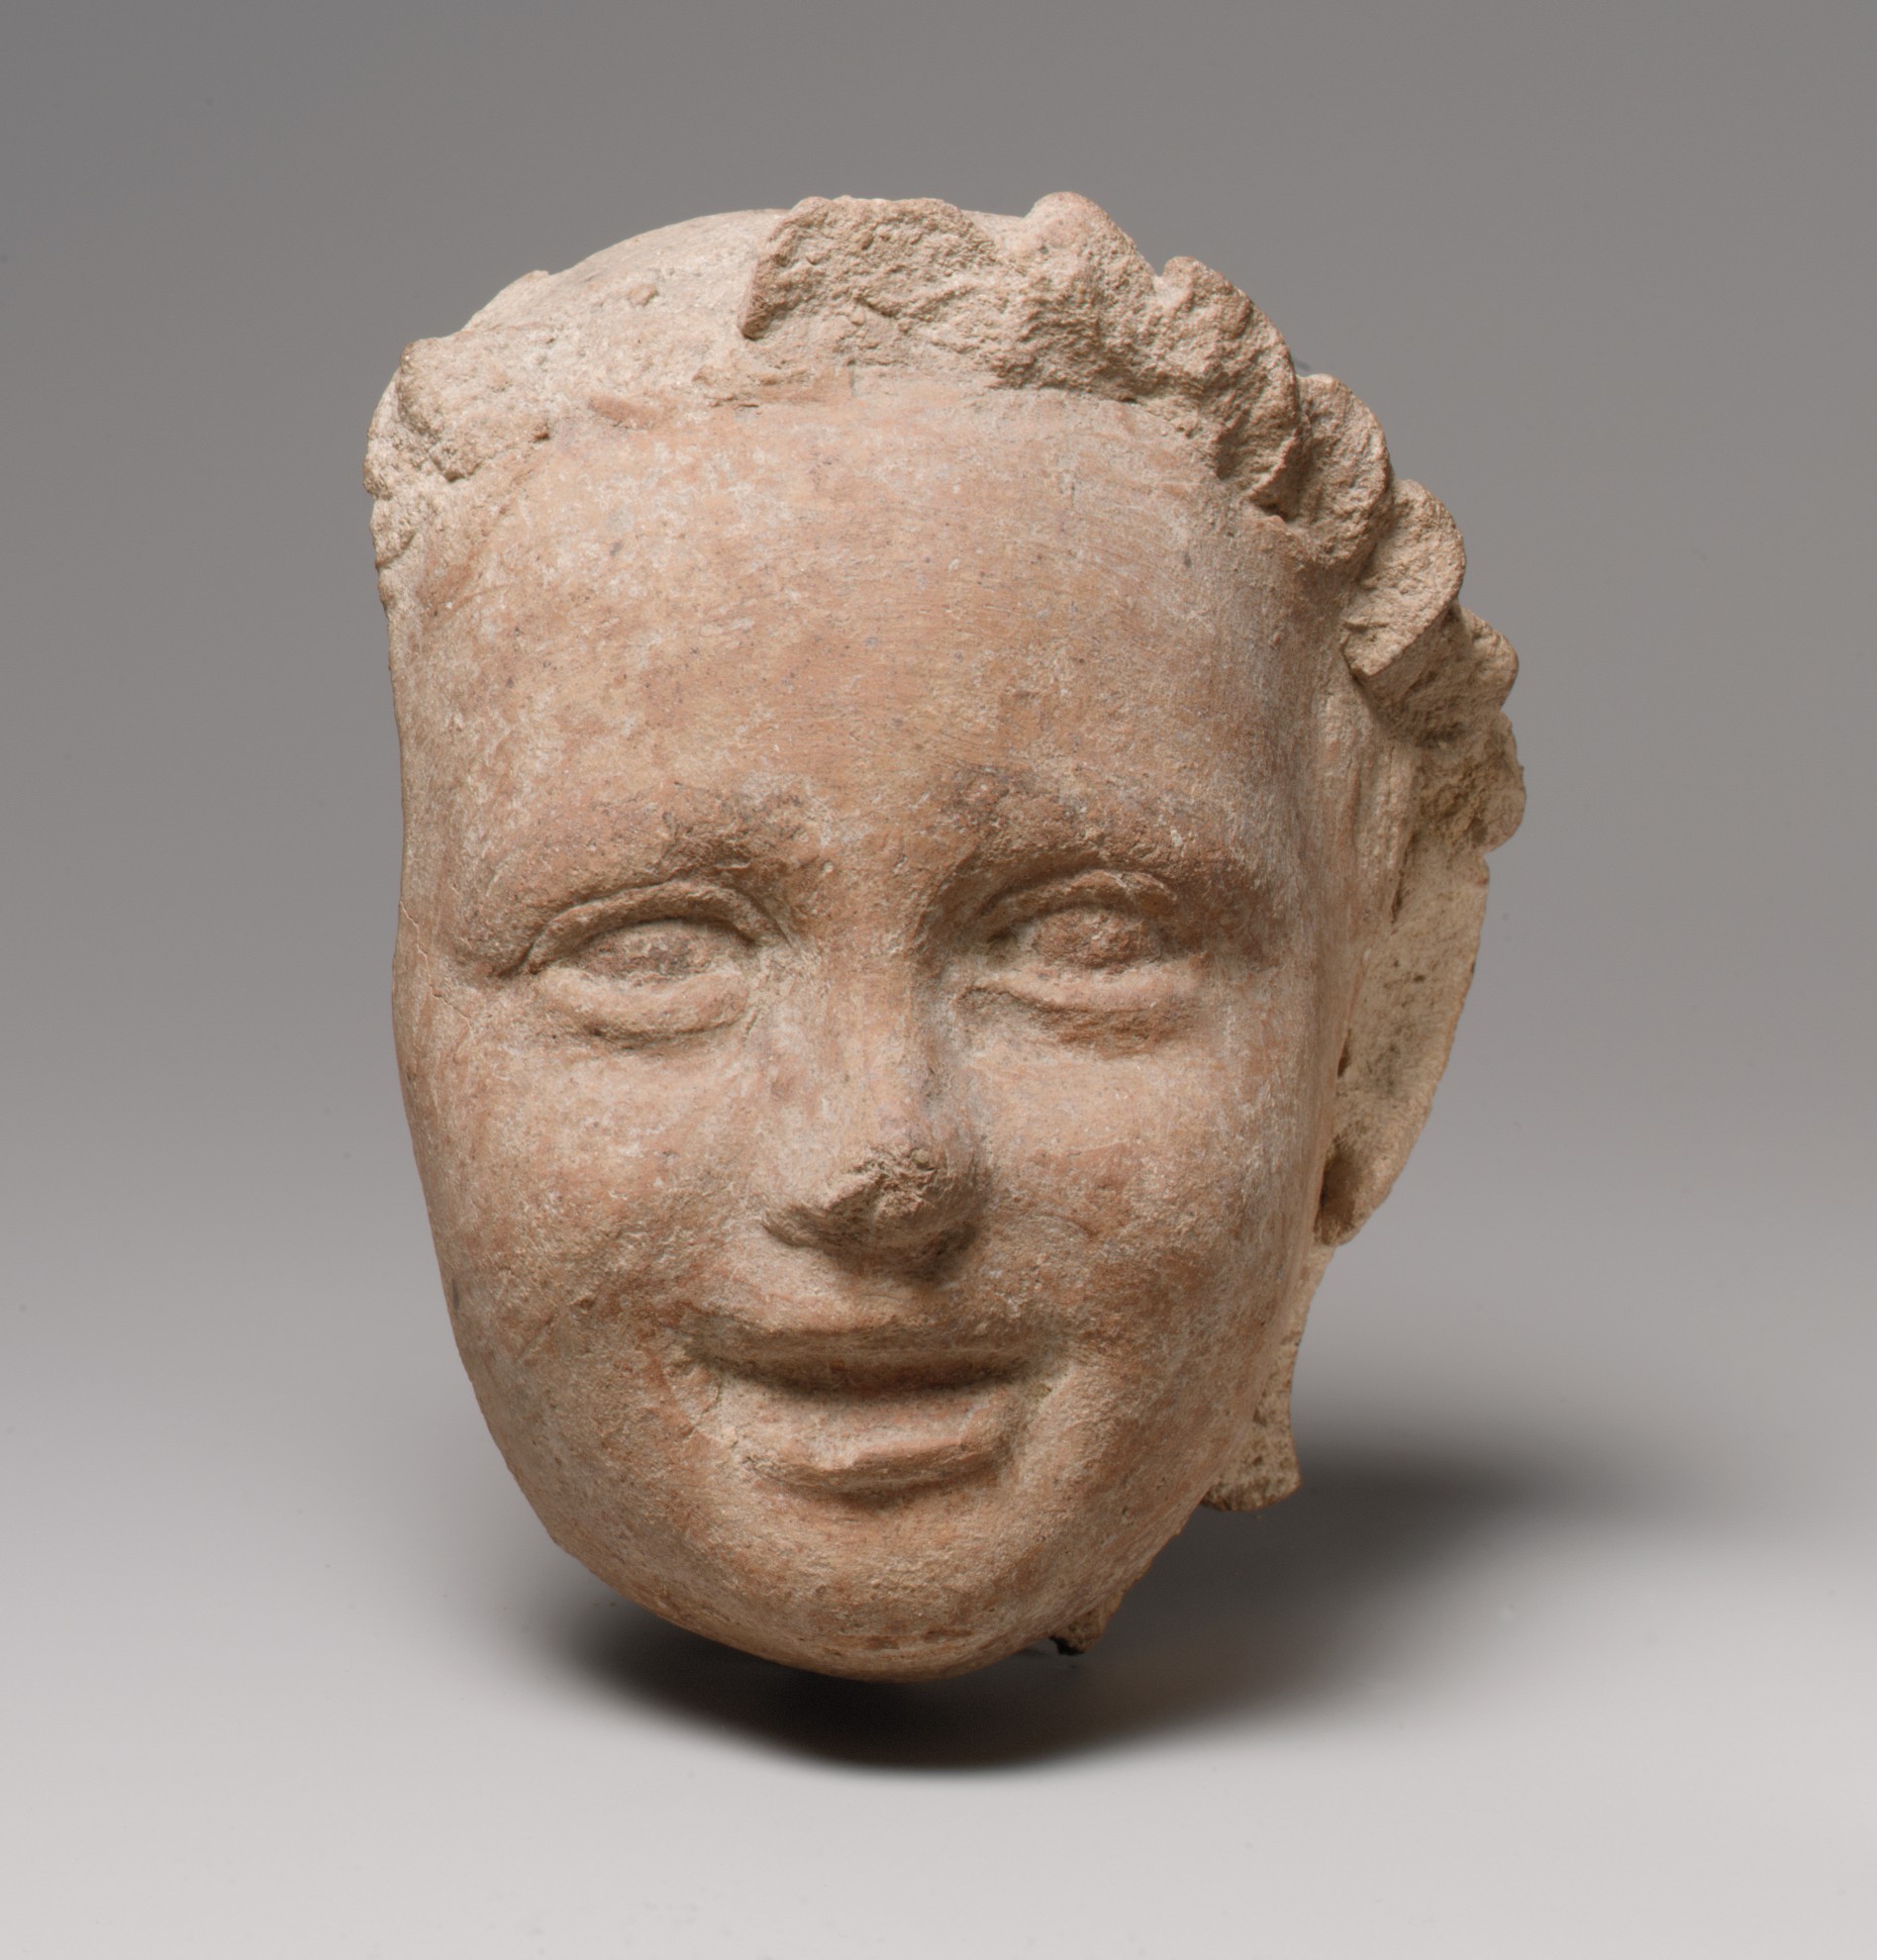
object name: head of a baby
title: Head of a boy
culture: cypriot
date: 300-201 BCE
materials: terracotta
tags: heads,boys